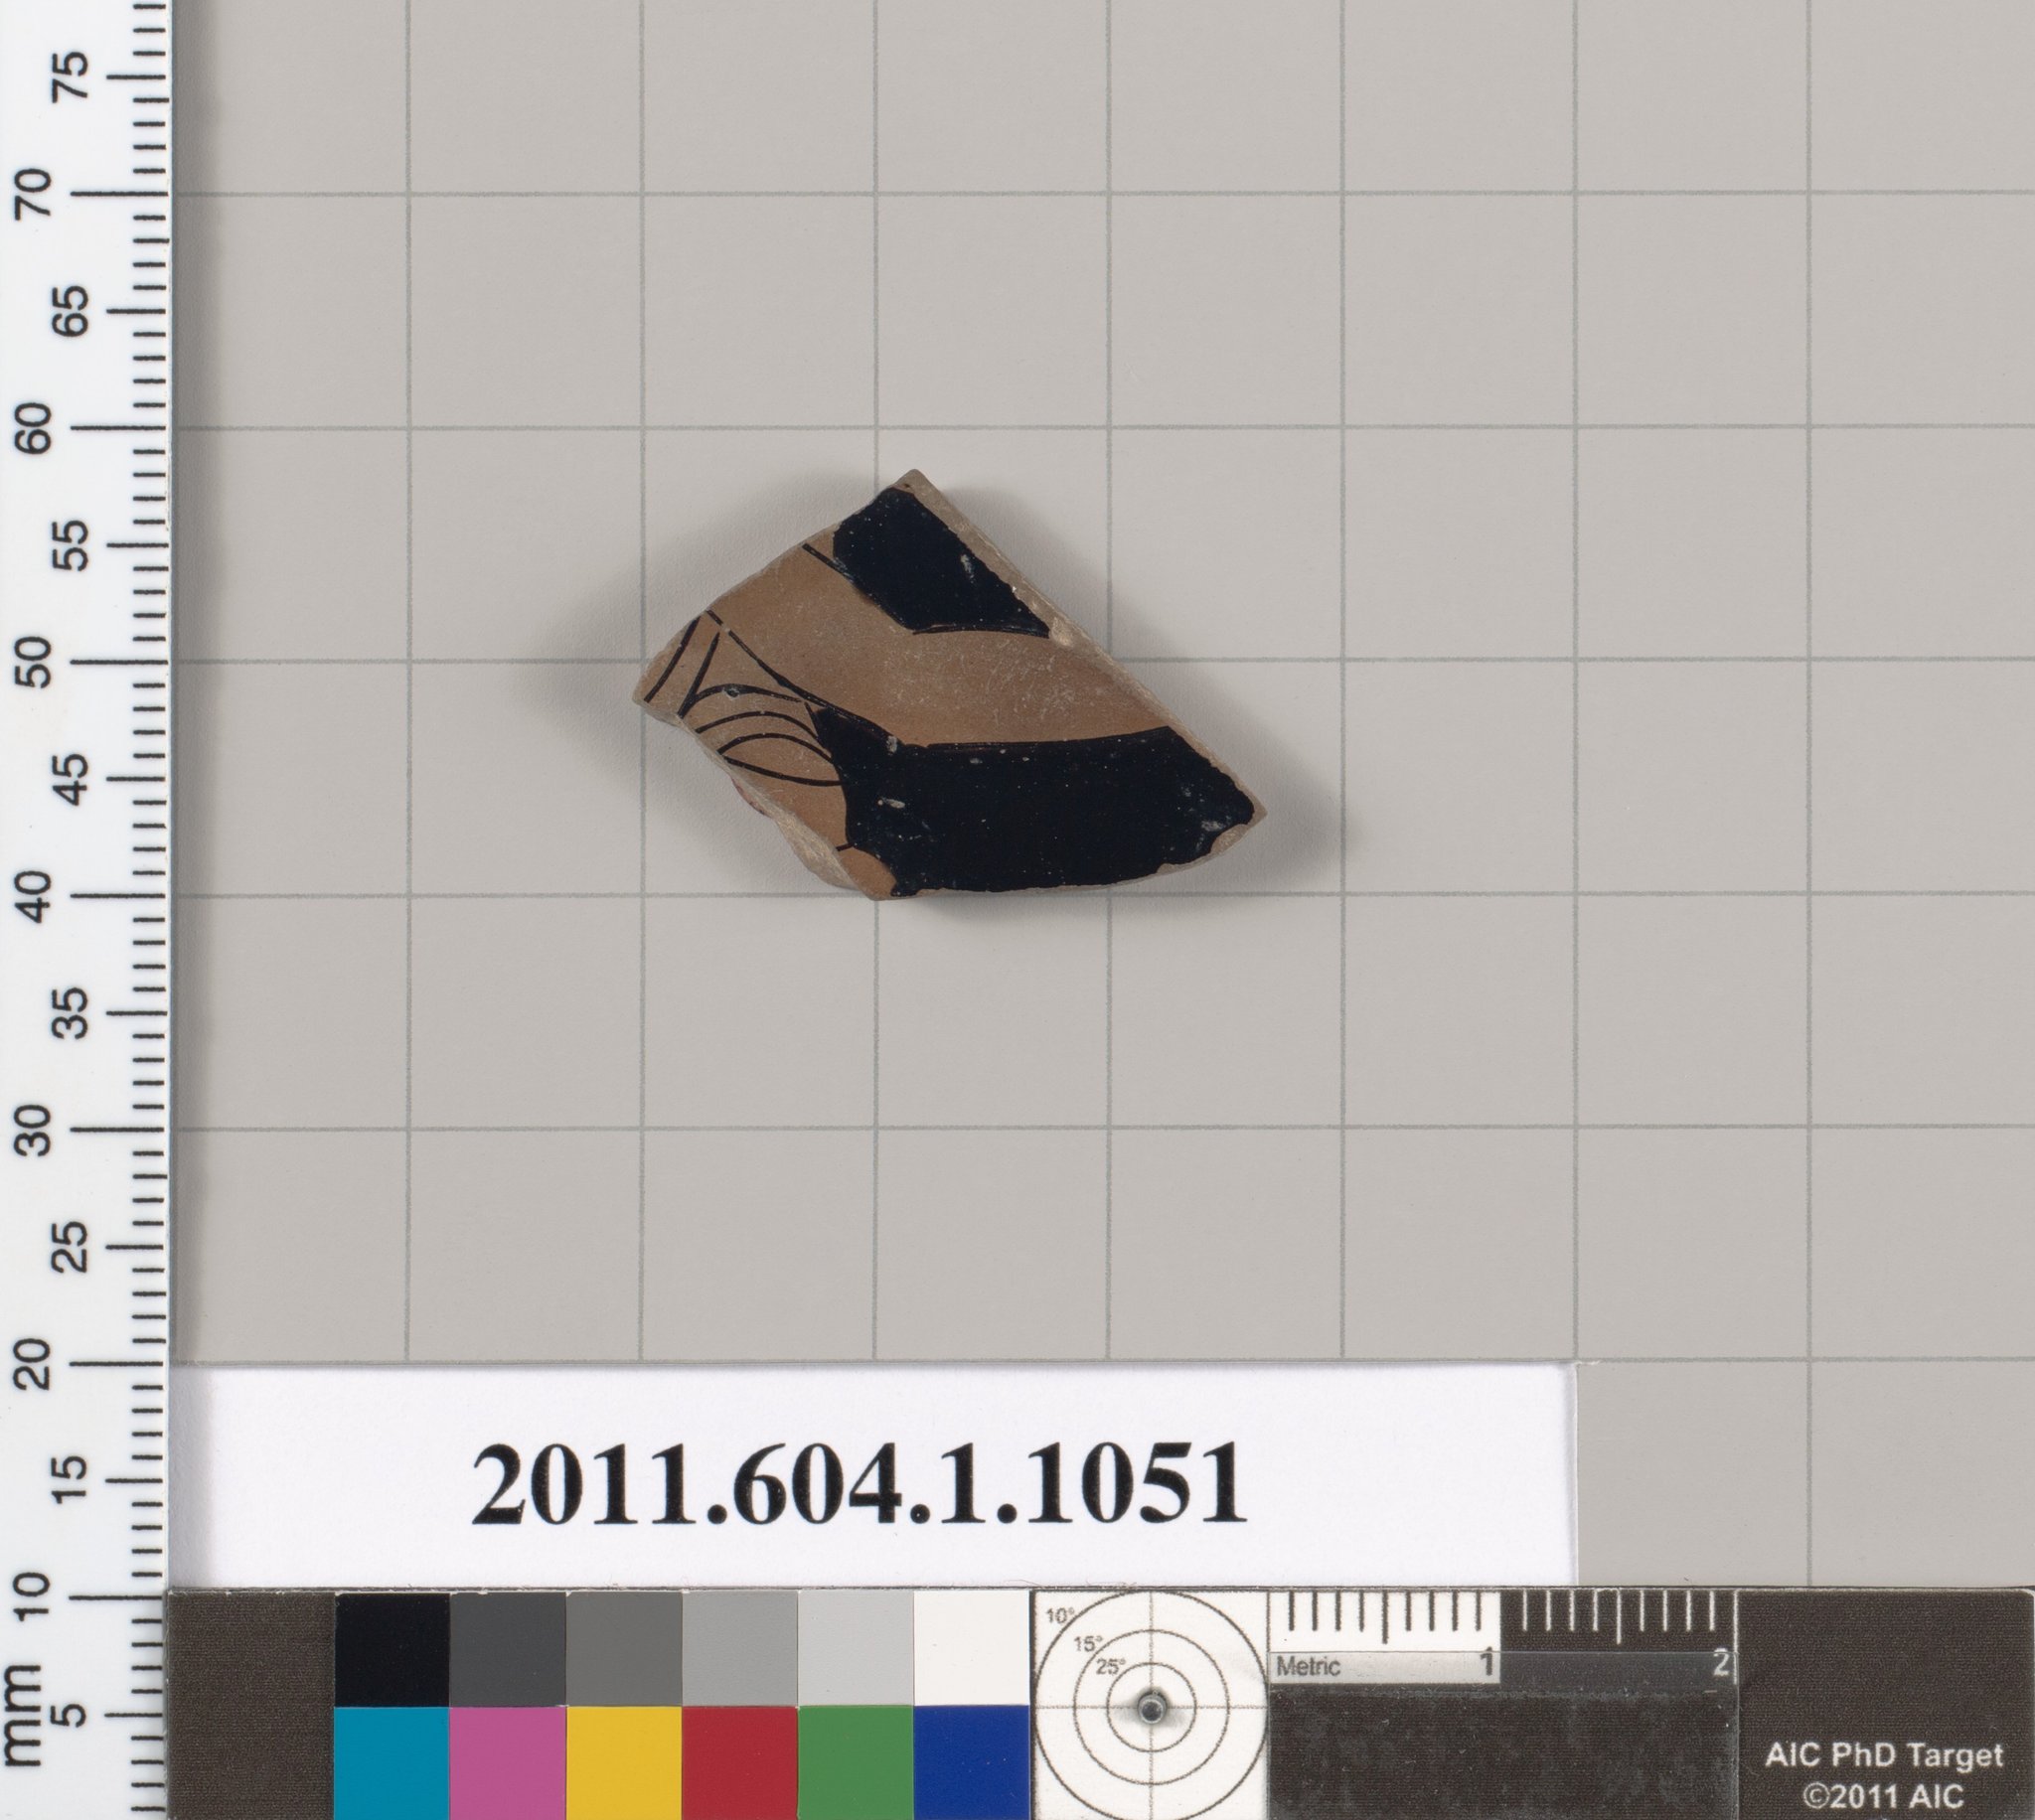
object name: kylix fragment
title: Terracotta fragment of a kylix (drinking cup)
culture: greek, attic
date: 475-451 BCE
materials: terracotta